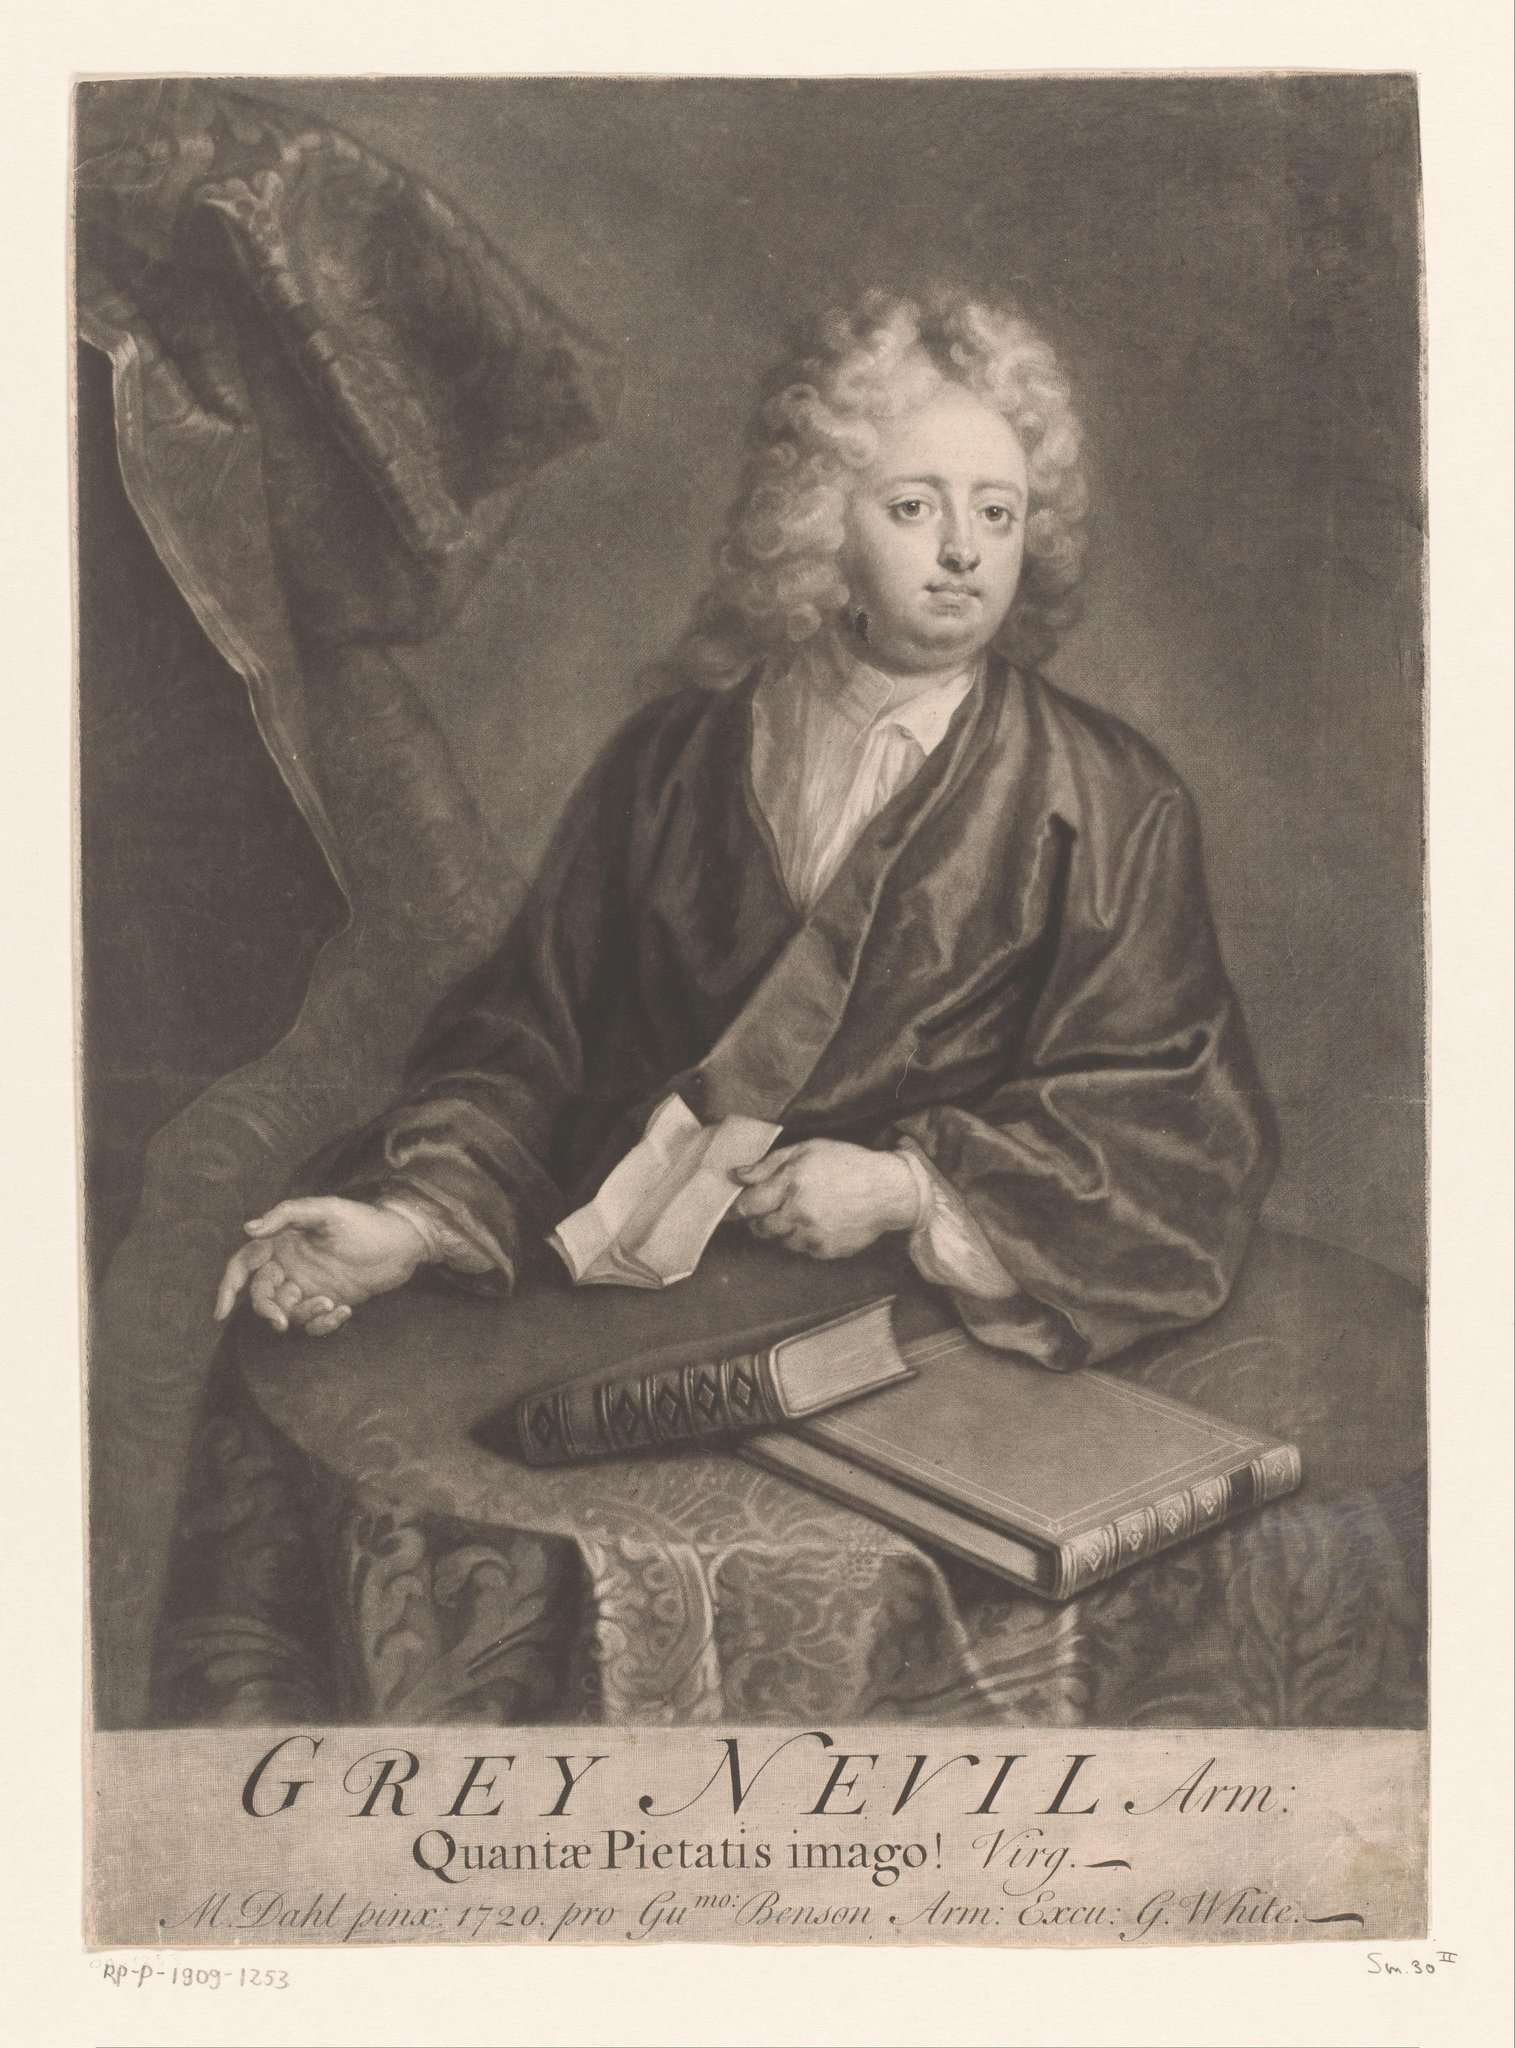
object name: print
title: Portret van Grey Nevil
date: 1720-1732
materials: paper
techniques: mezzotint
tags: politician, historical persons, politician, e.g. party leader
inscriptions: collector's mark: Lugt 2228